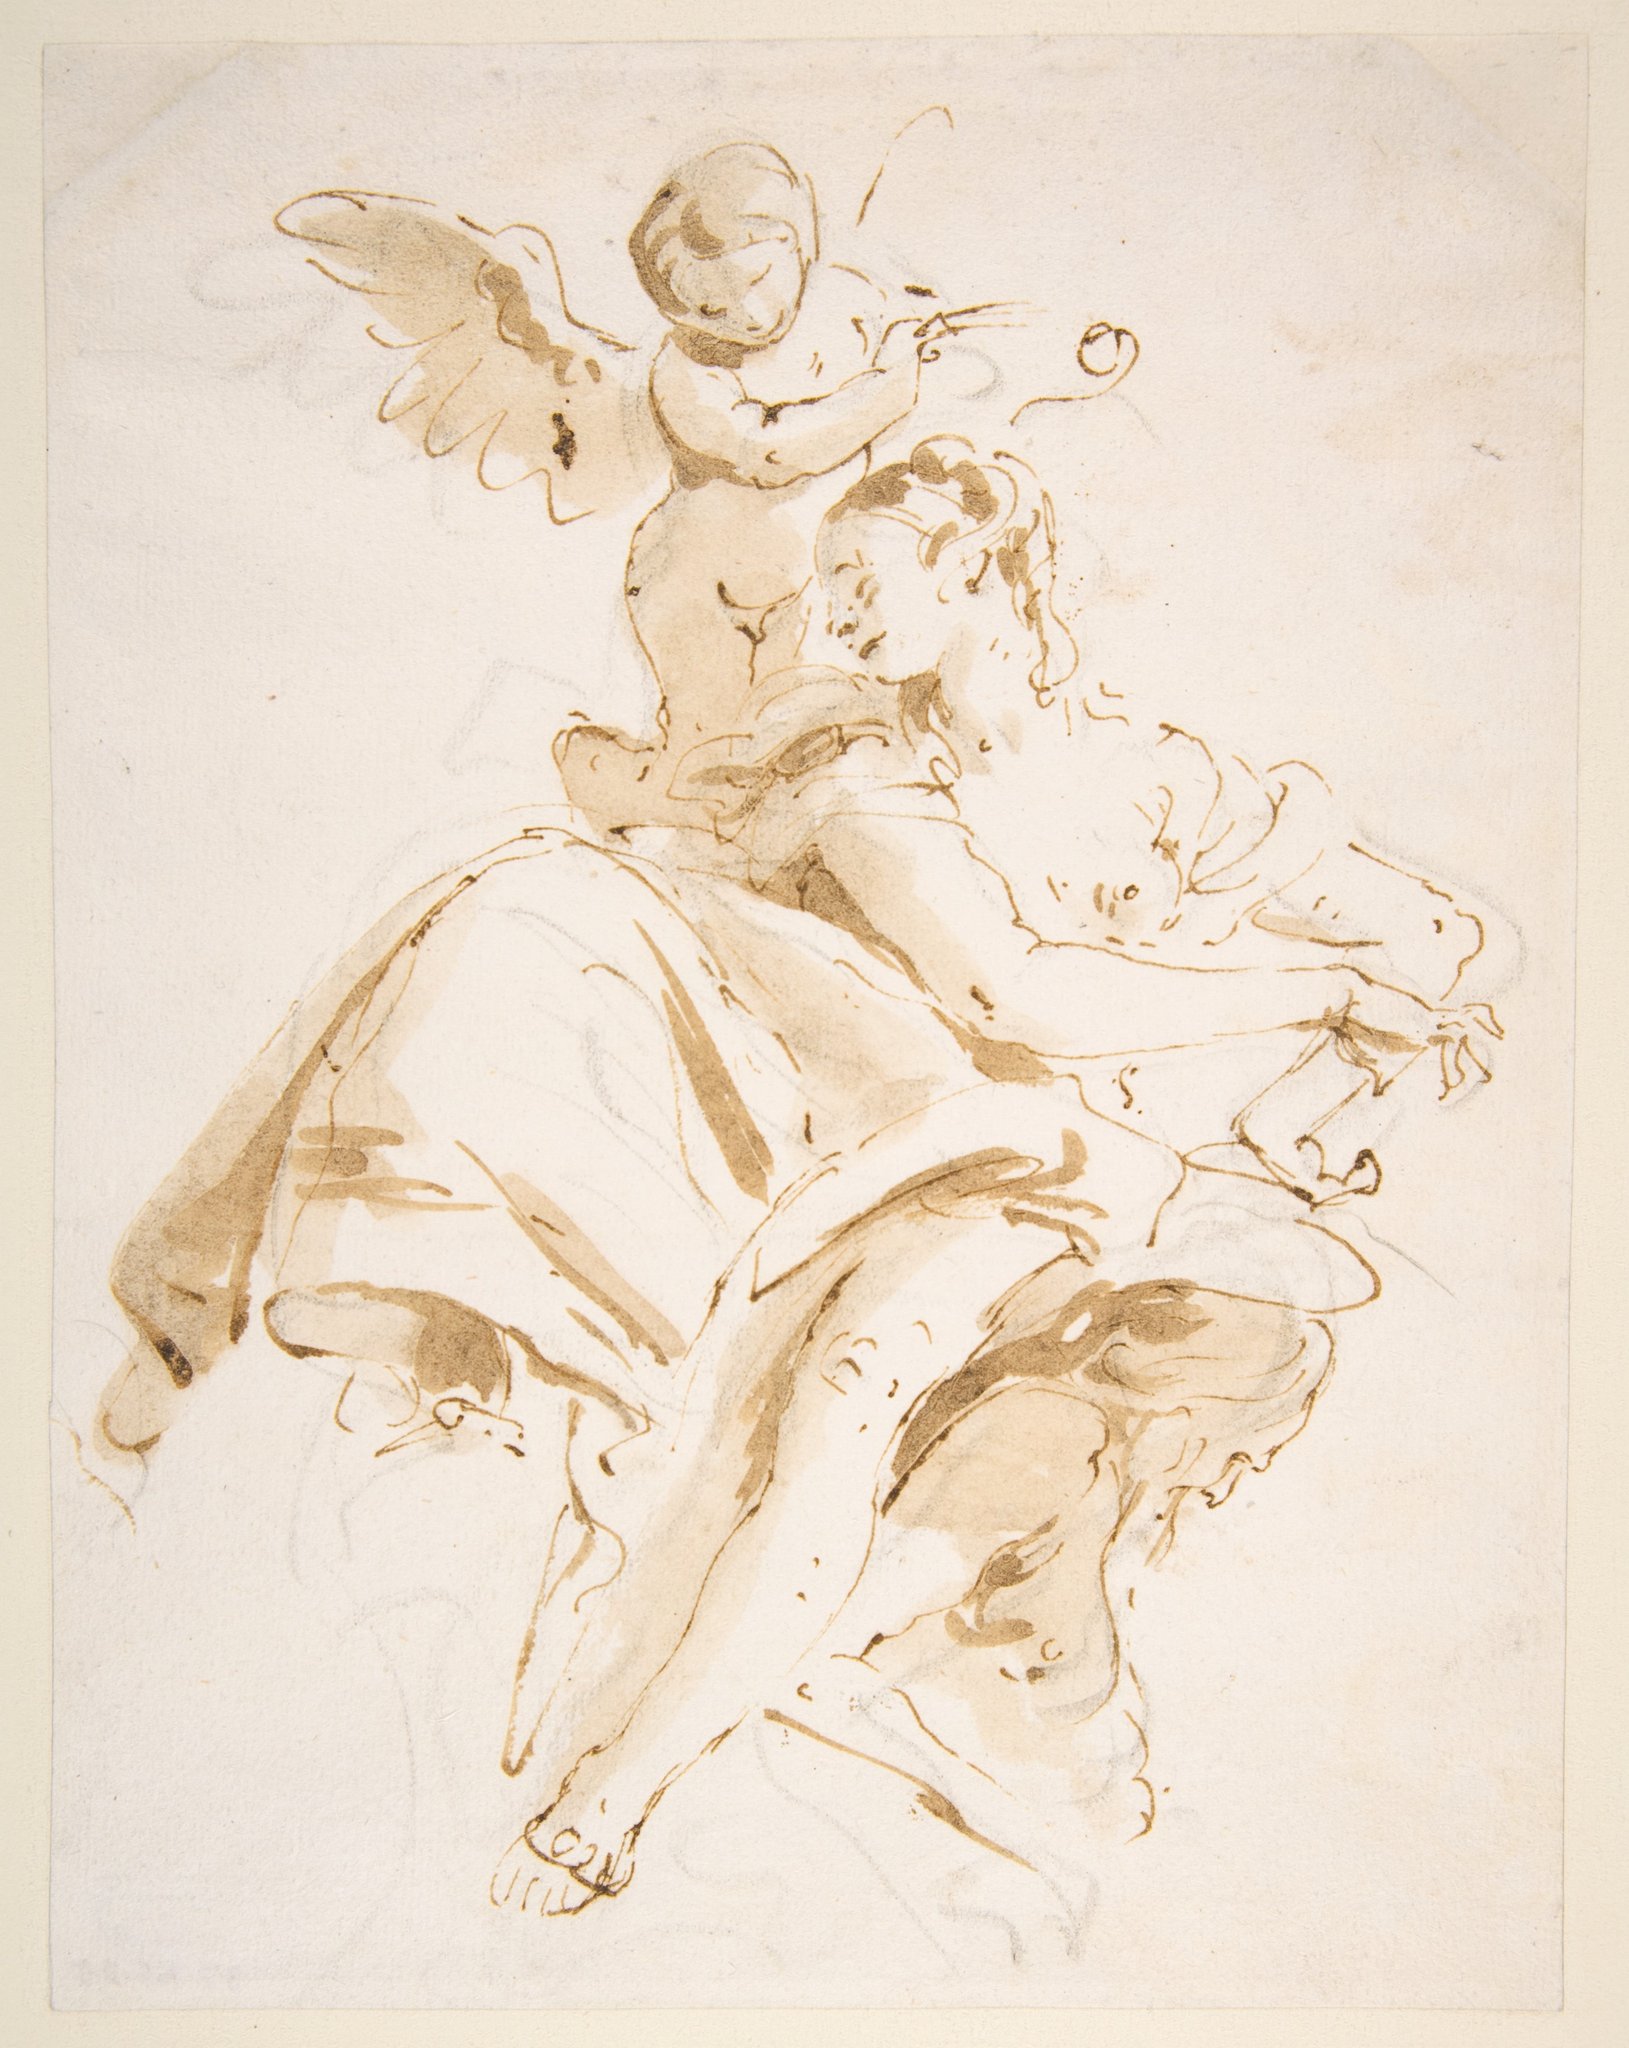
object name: drawing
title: Winged Putto Crowning a Seated Woman Who Looks to the Left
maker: giovanni battista tiepolo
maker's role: artist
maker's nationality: italian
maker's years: 1696-1770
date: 1696-1770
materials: chalk, ink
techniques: brush, pen, wash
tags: women,putti